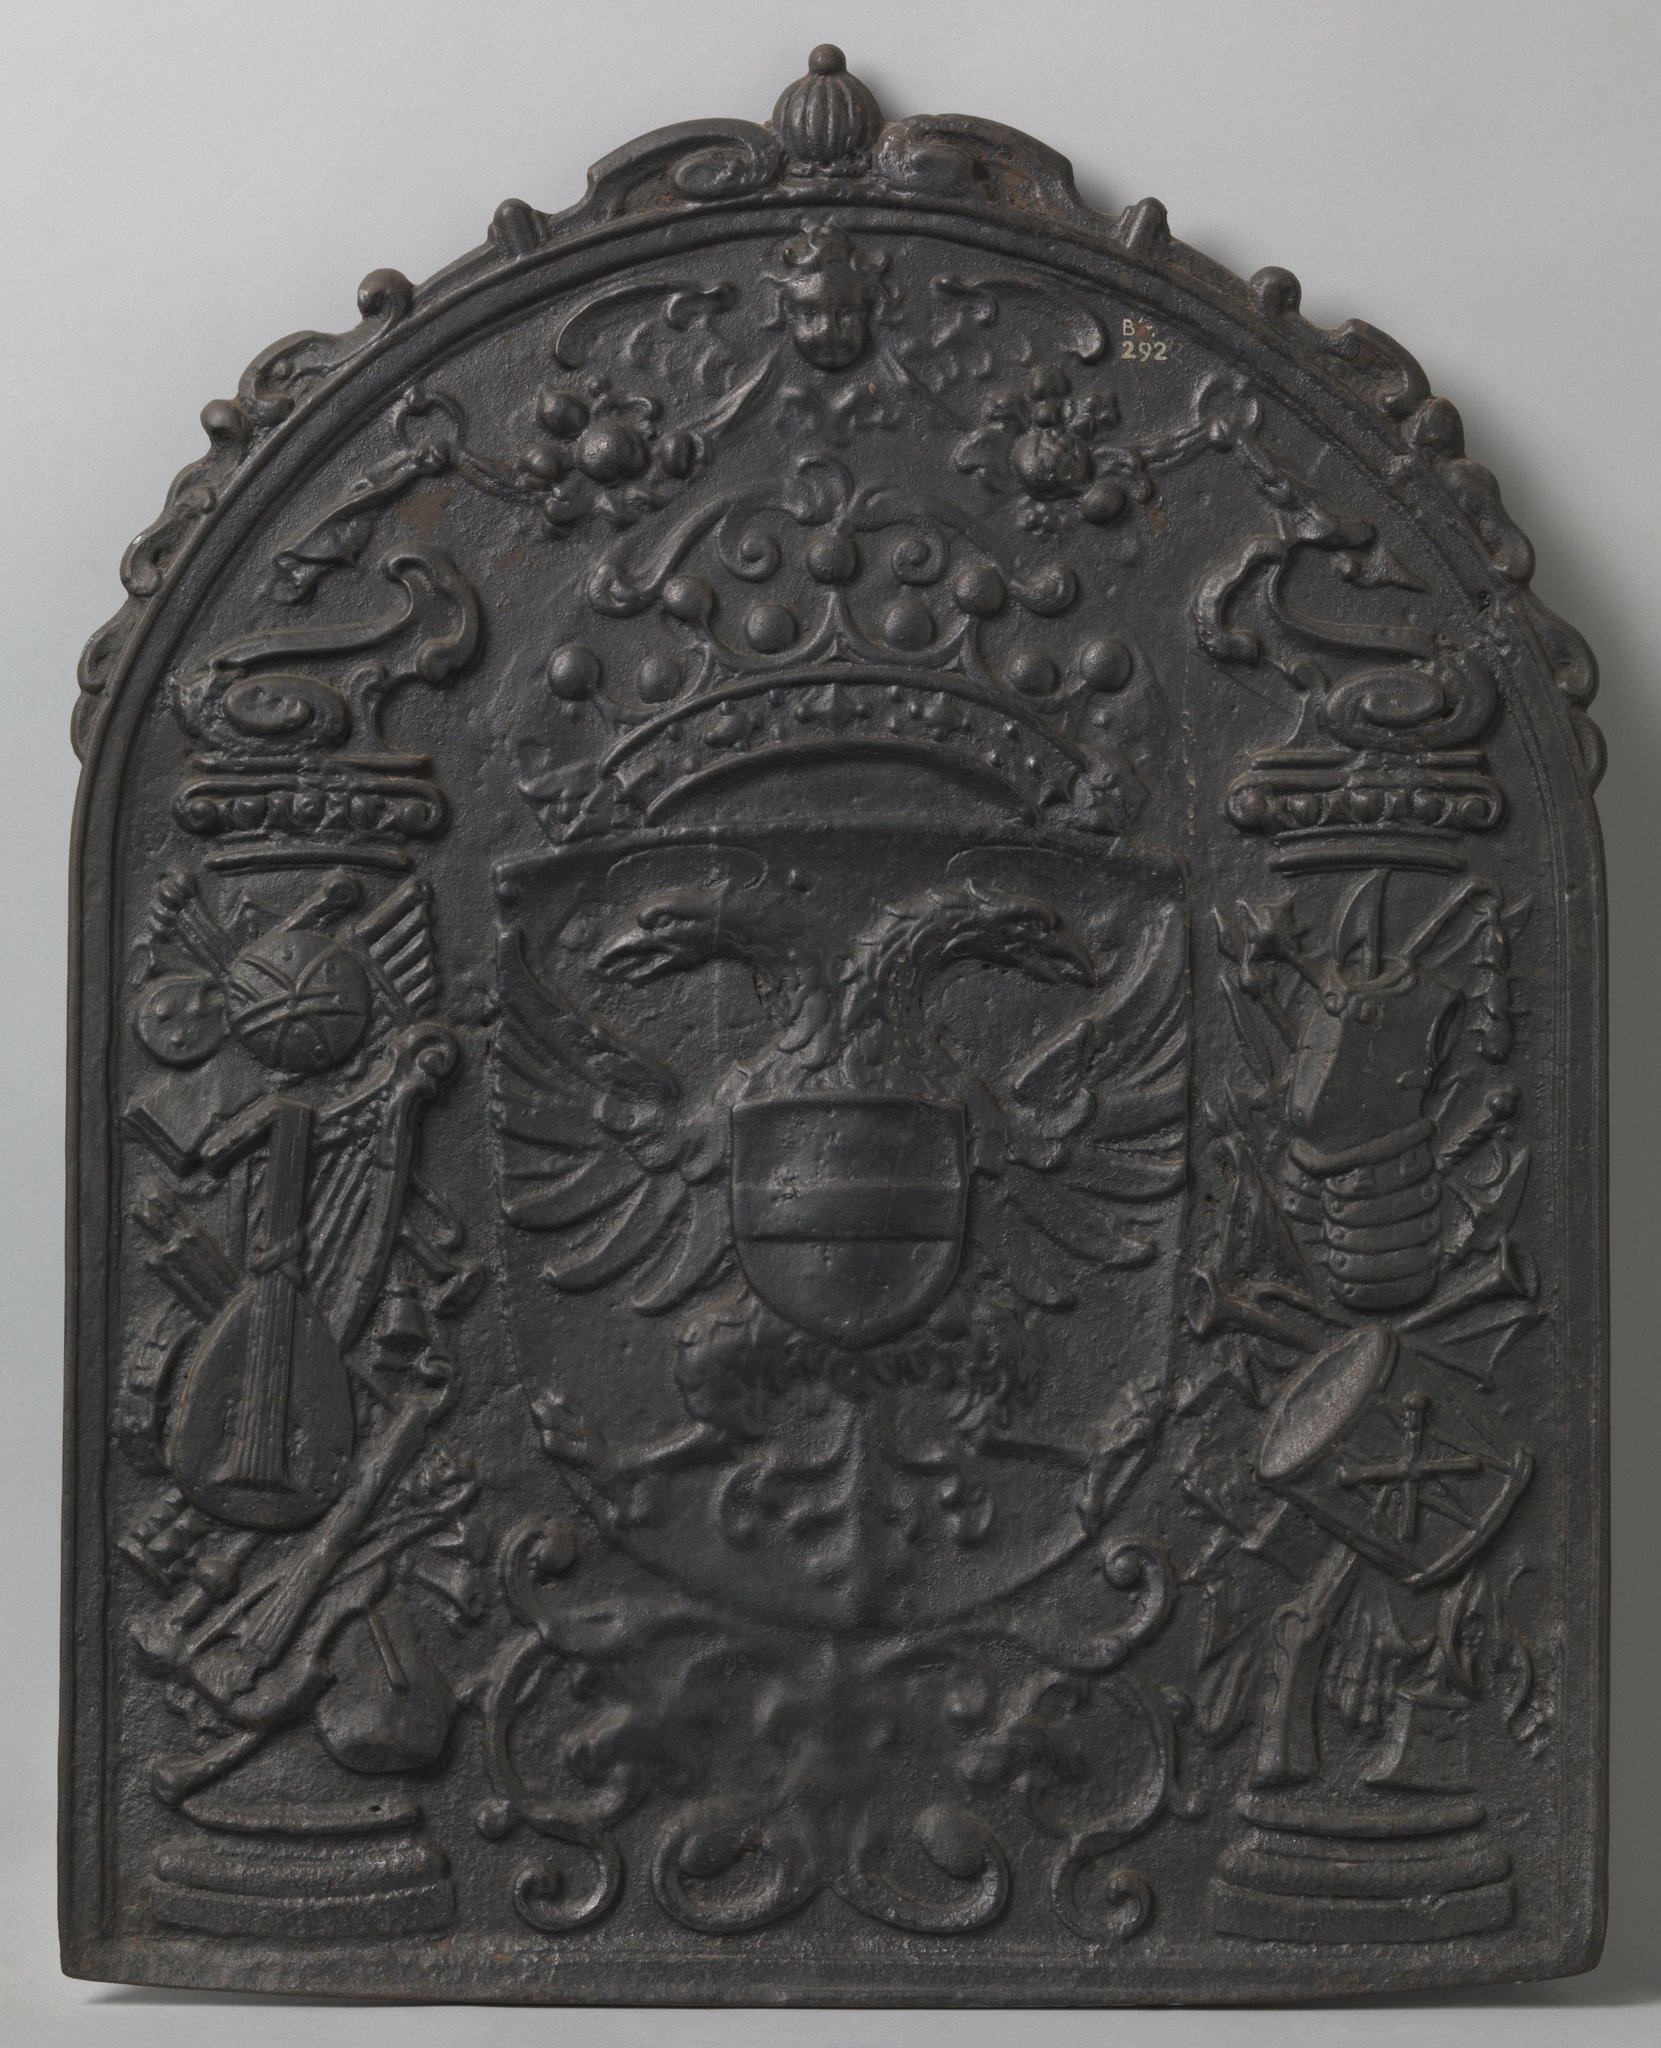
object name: fireback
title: Haardplaat met het stadswapen van Groningen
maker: Anonymous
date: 1625-1675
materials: iron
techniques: casting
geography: germany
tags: groningen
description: Haardplaat van gietijzer, met een halfronde bovenzijde. Centraal is het gekroonde stadswapen van Groningen te zien, met aan weerszijden een festoen. Bovenaan een engelenkopje met daarnaast bloemornamenten, onderaan een symmetrisch rankenornament. Het geheel wordt bekroond met een granaatappel met aan weerszijden nog enkele decoratieve elementen.